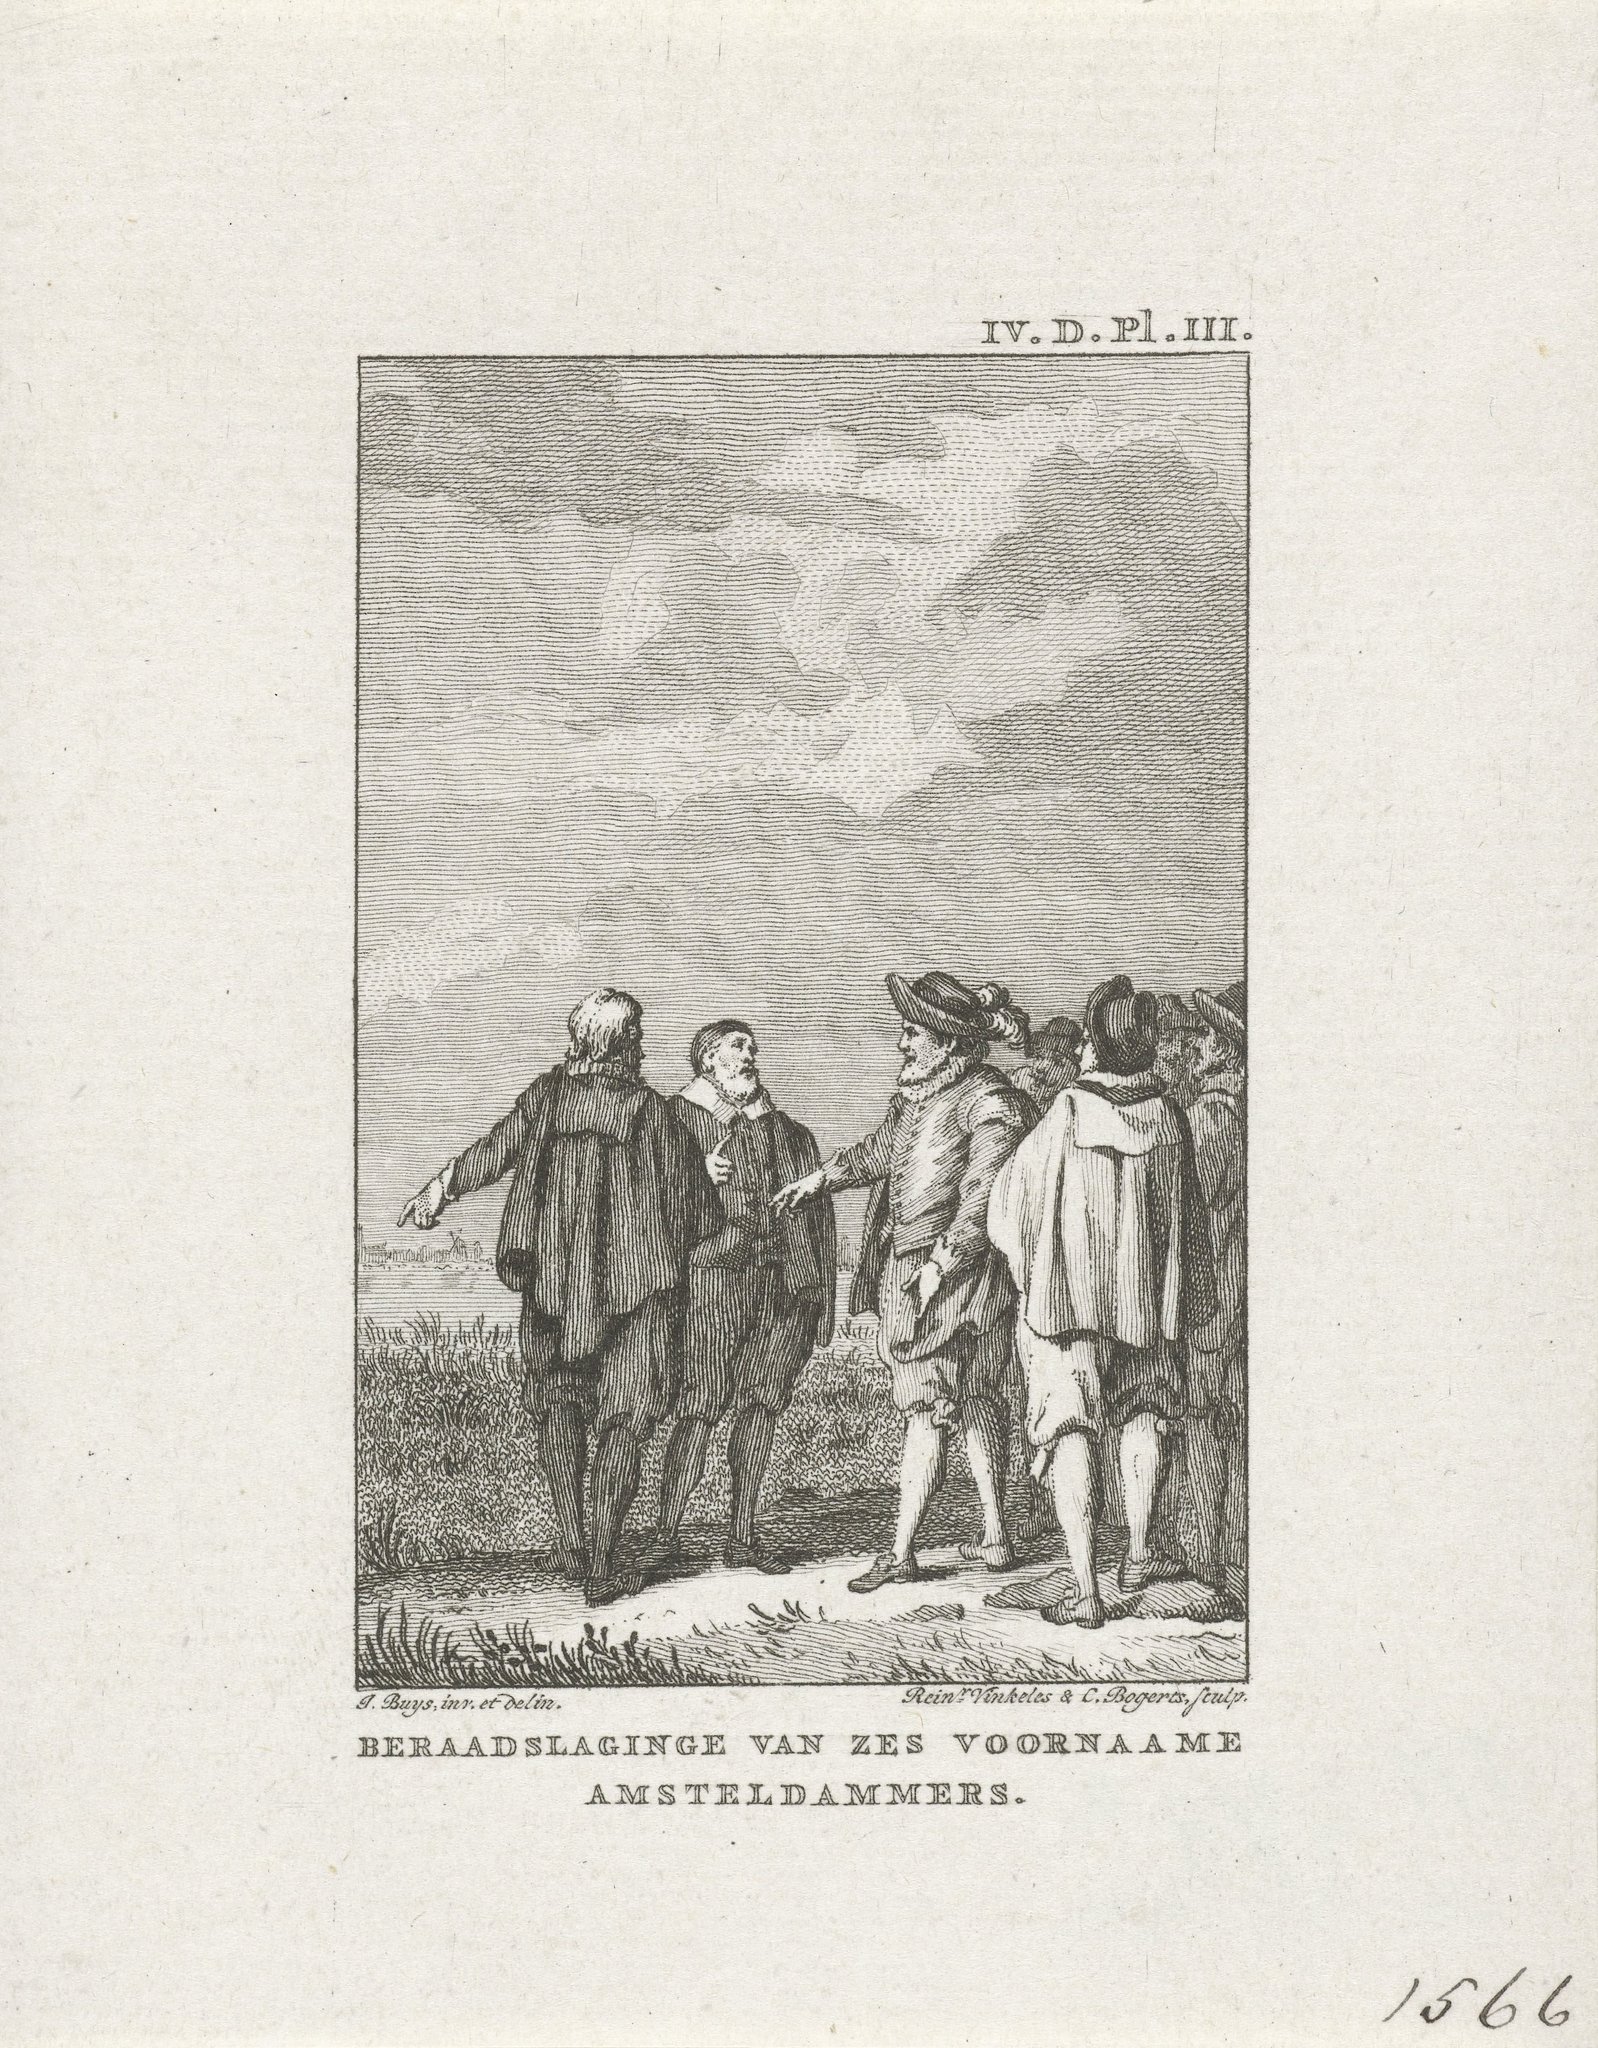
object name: history print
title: Overleg tussen zes voorname Amsterdammers, 1566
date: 1780-1795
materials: paper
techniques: etching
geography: netherlands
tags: debate, discussion (~ meeting), amsterdam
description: Illustratie voor: J. Fokke, Geschiedenissen der Vereenigde Nederlanden voor de vaderlandsche jeugd, Johannes Allart, Amsterdam 1783-1795, 25 delen, dl. IV, pl. III. Staat met de letter.